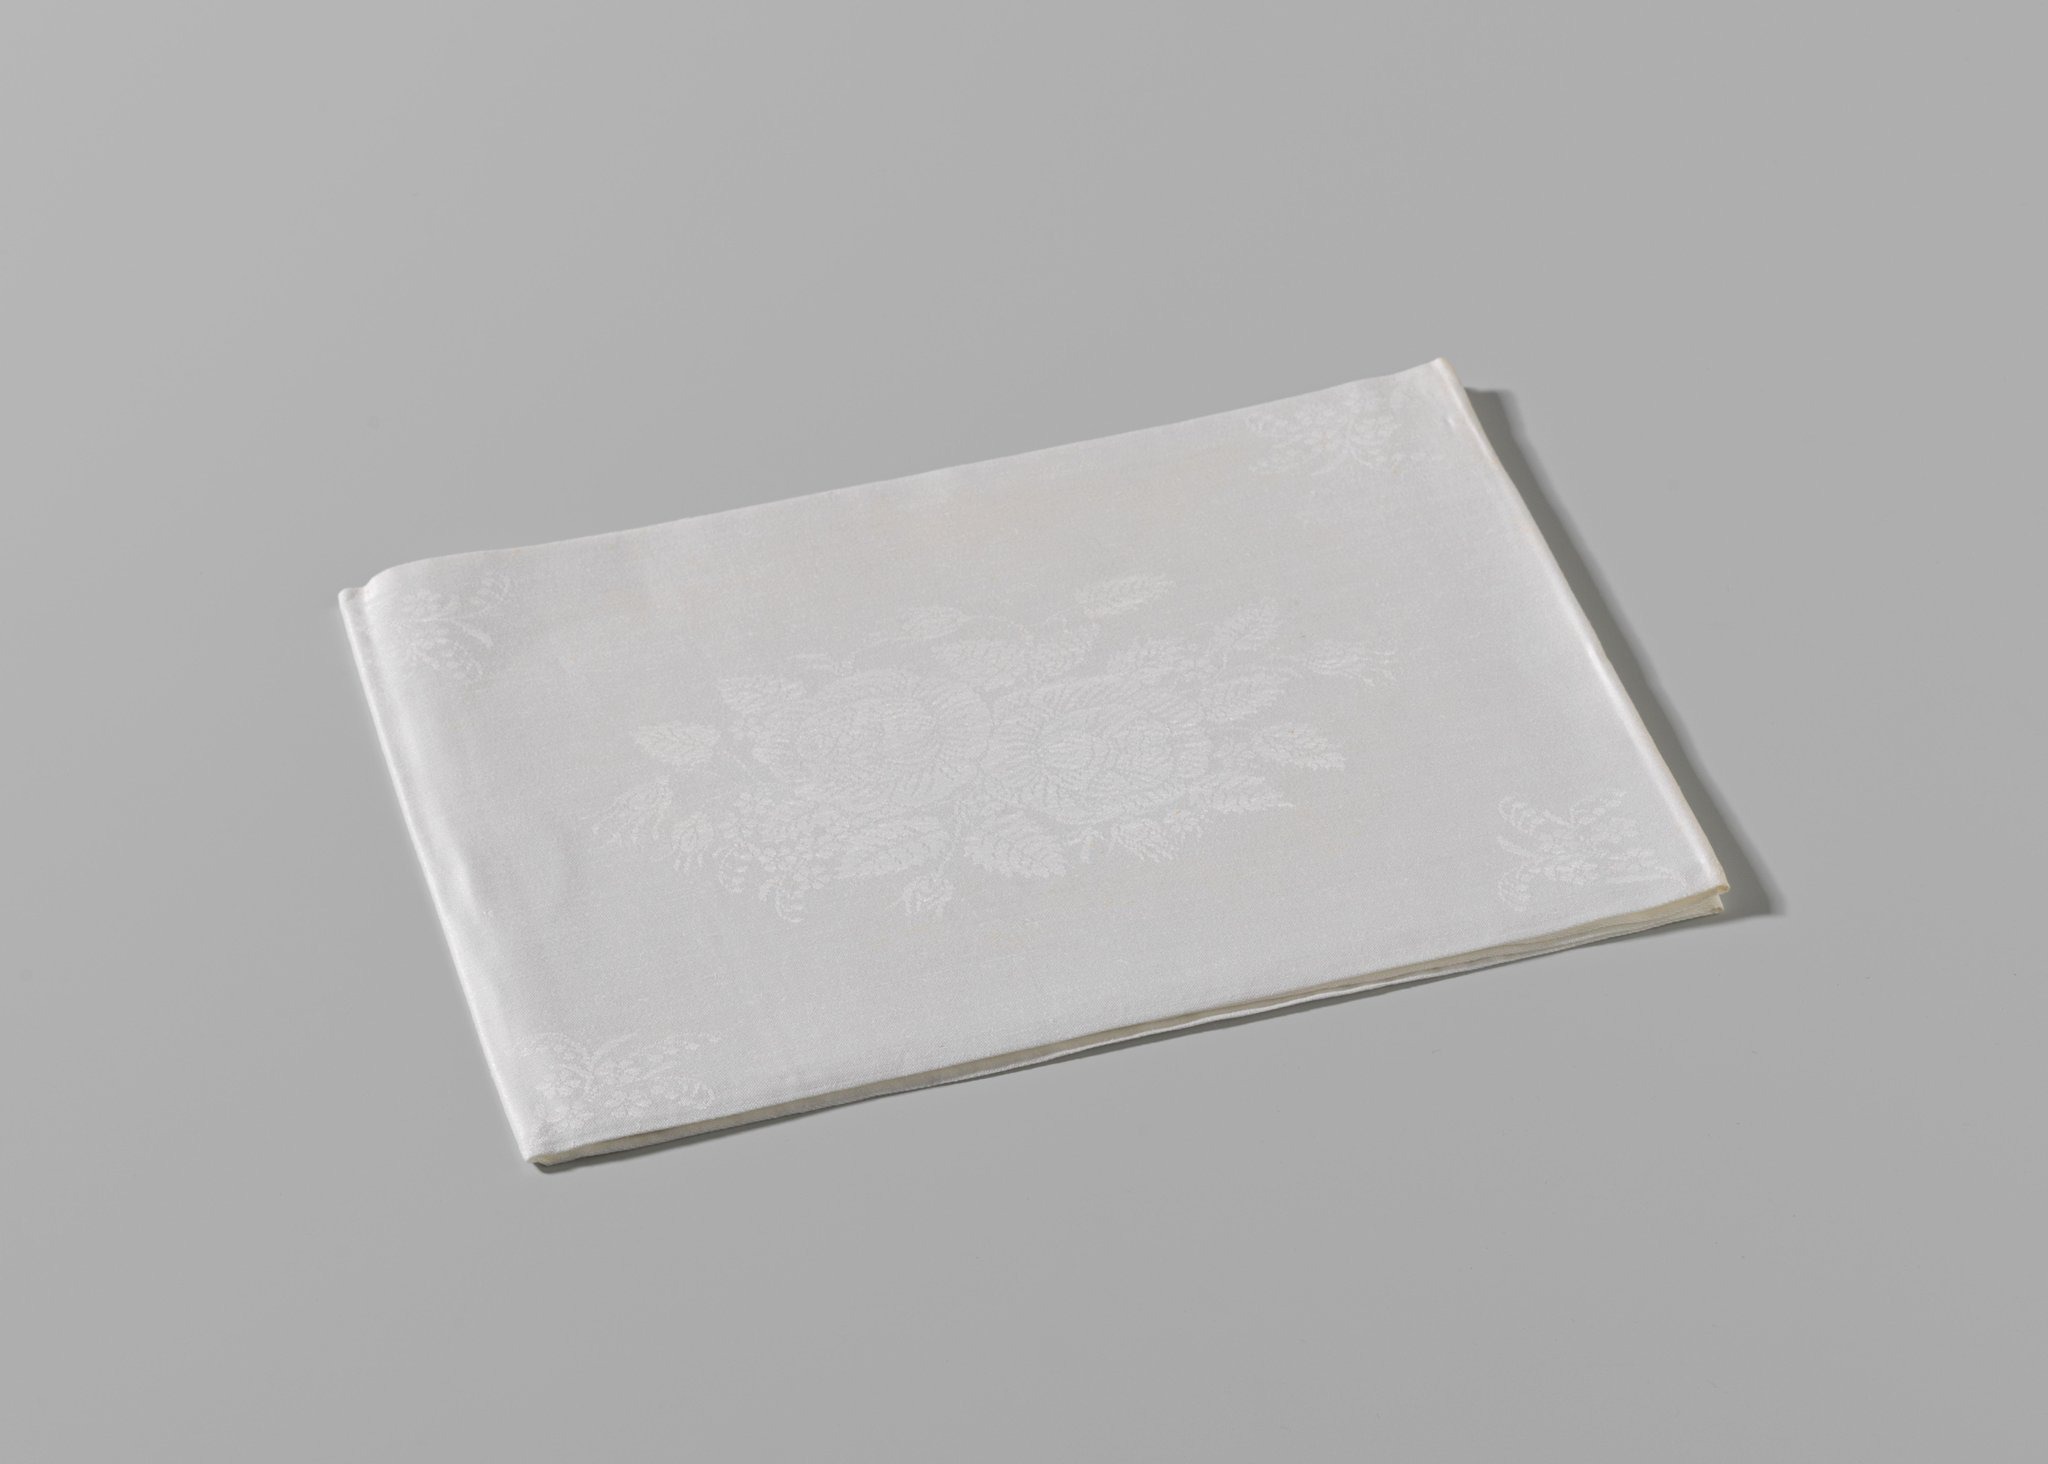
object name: napkin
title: Servet met rozen en vergeet-mij-nietjes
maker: Anonymous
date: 1725-1749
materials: linen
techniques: damask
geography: dresden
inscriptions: mark: ‘BS 18’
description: Servet van linnendamast met rozen en vergeet-mij-nietjes. Rozen- afgewisseld met vergeet-mij-niettuiltje. Brede rand met fijne symmetrische rocaillemotieven met rastervulling en met naar binnen gerichte bloemenvazen, waarin drie afwisselende bloembouquetten. Binnenzoom van C-motieven; buitenbegrenzing van bloemslingers. Rondom: blokkenrand.